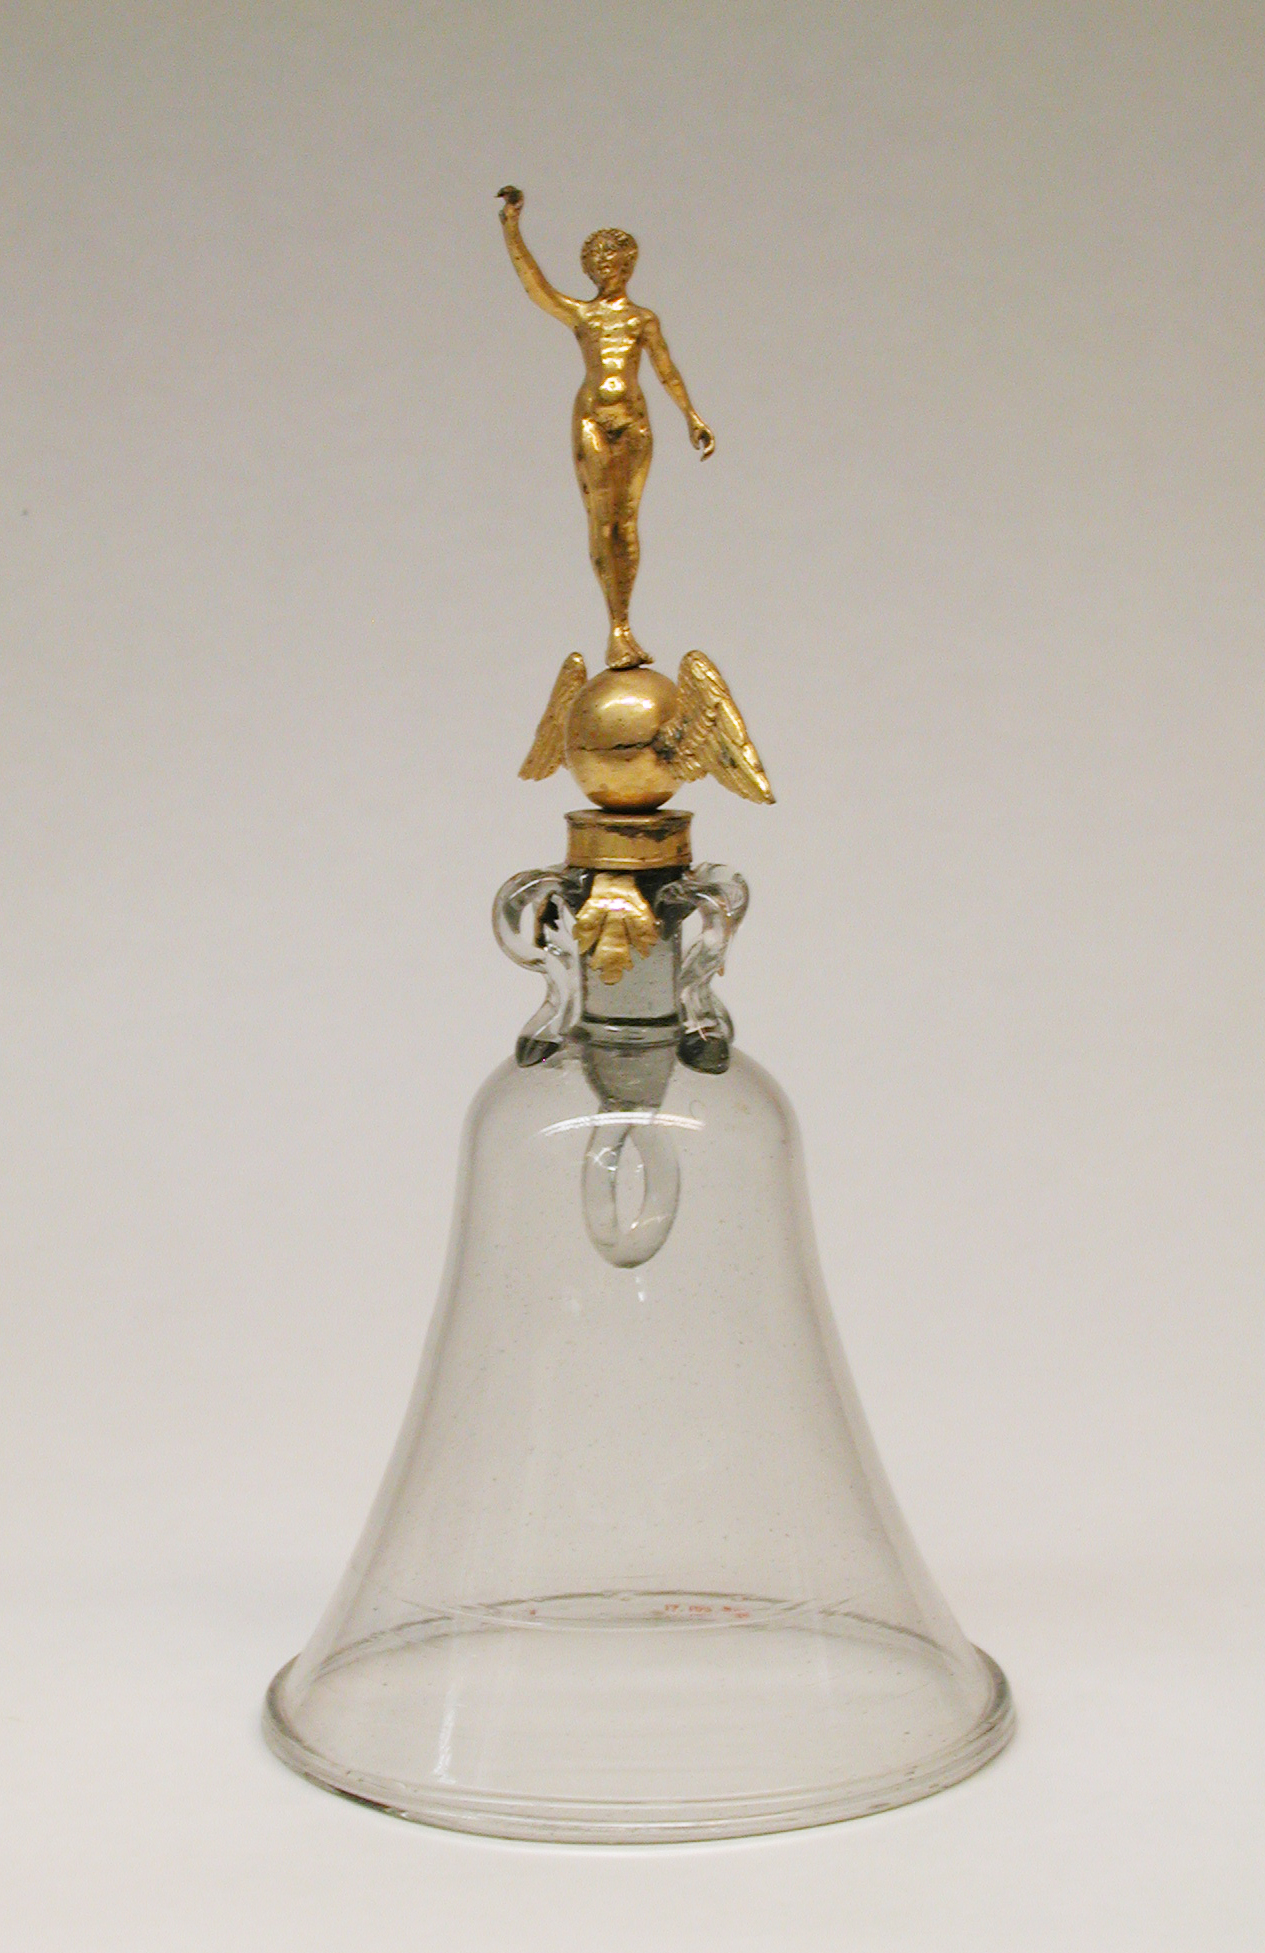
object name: bell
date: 1567-1600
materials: gilt bronze, glass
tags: musical instruments,female nudes